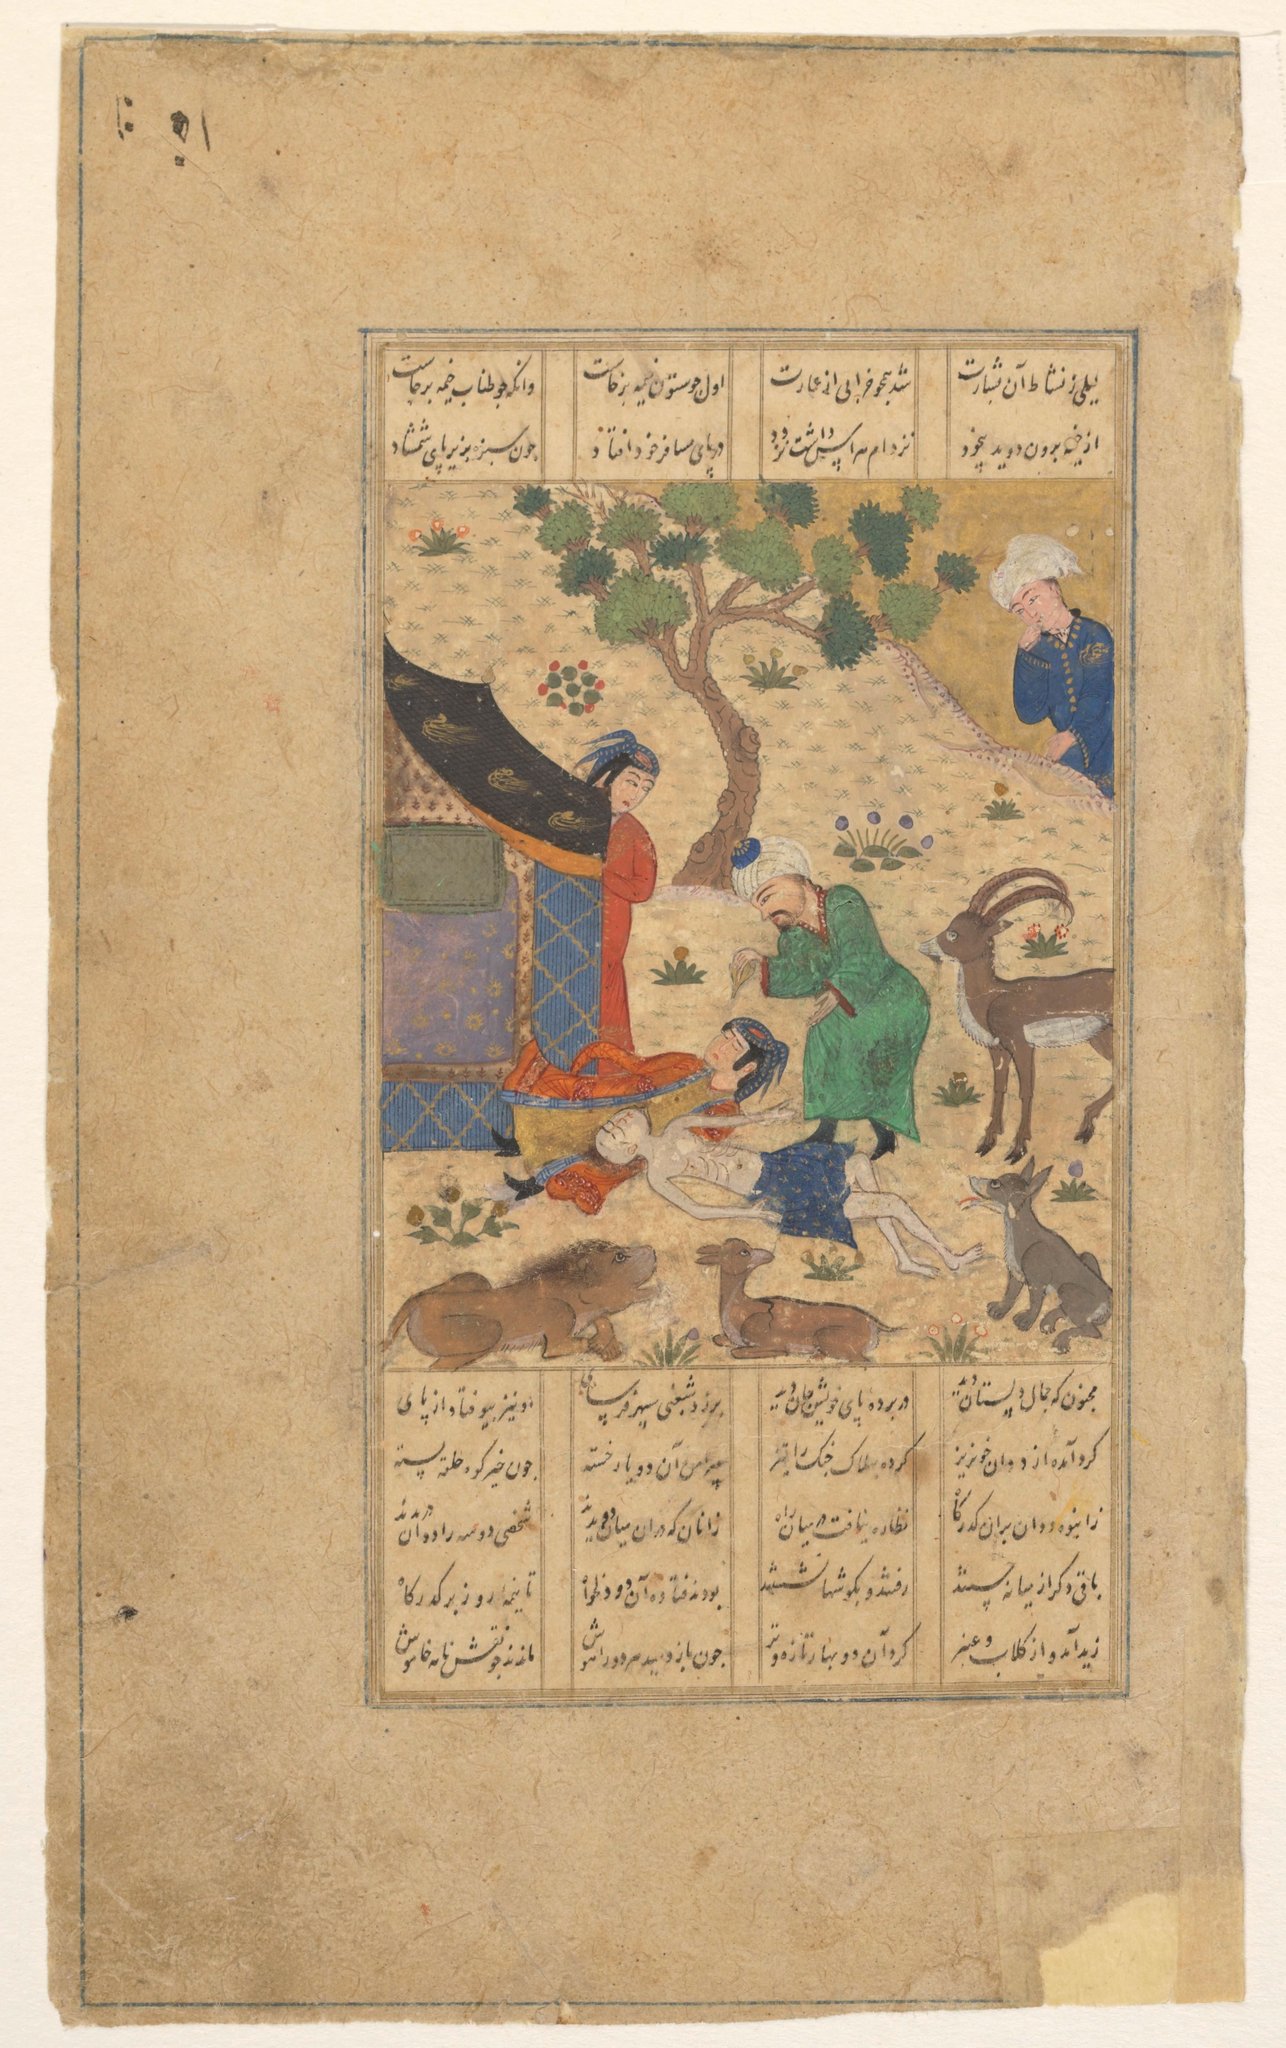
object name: persian miniature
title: Laila en Mainum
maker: Anonymous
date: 1500-1600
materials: paper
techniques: brush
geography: iran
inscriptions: inscription, inscription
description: In een veld met dieren ligt een vrouw met een dode man half over haar heen, een man staat half over de vrouw gebogen en besprenkelt haar uit een flesje, een vrouw houdt een groot zwart kleed omhoog en achter de heuvels is een halve figuur zichtbaar; een perzische tekst in vier kolommen loopt boven- en onderaan de voorstelling. De voorstelling wordt omlijst door een brede verkleurd ivoren bladrand en ligt naar de rechterkant van het blad.